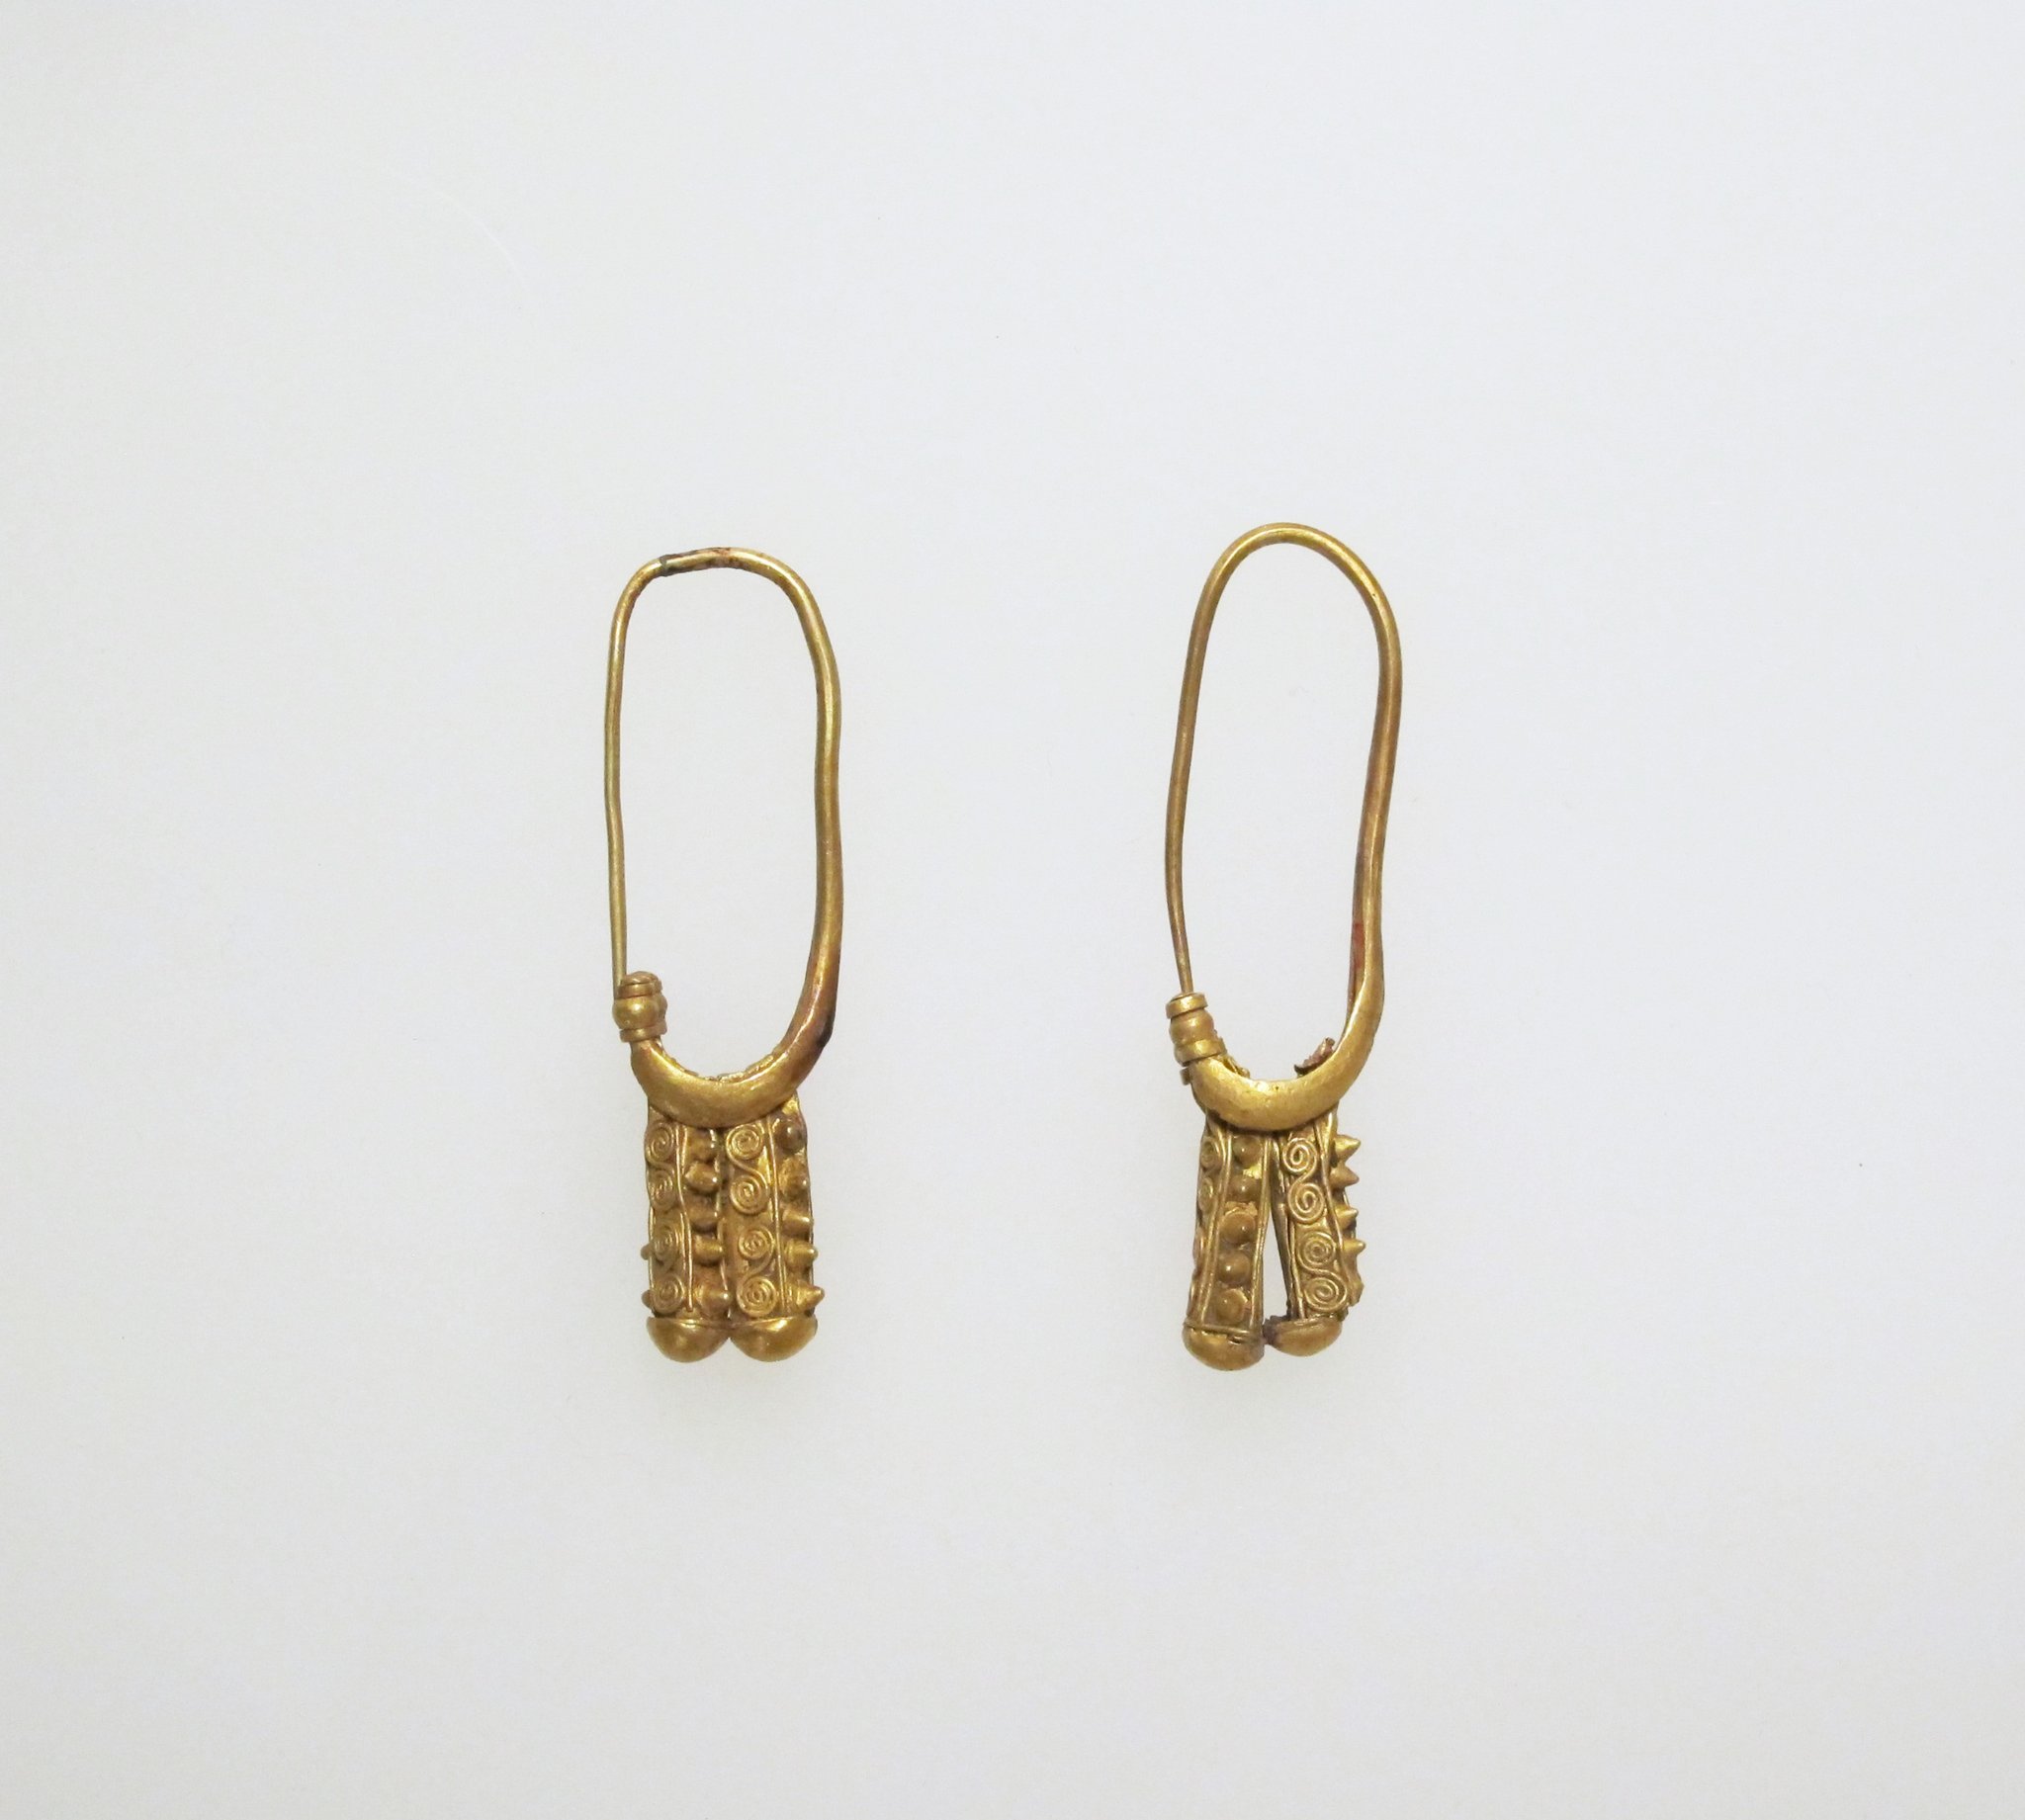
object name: earring, boat shaped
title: Earring, boat-shaped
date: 7000 BCE-330 CE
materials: gold